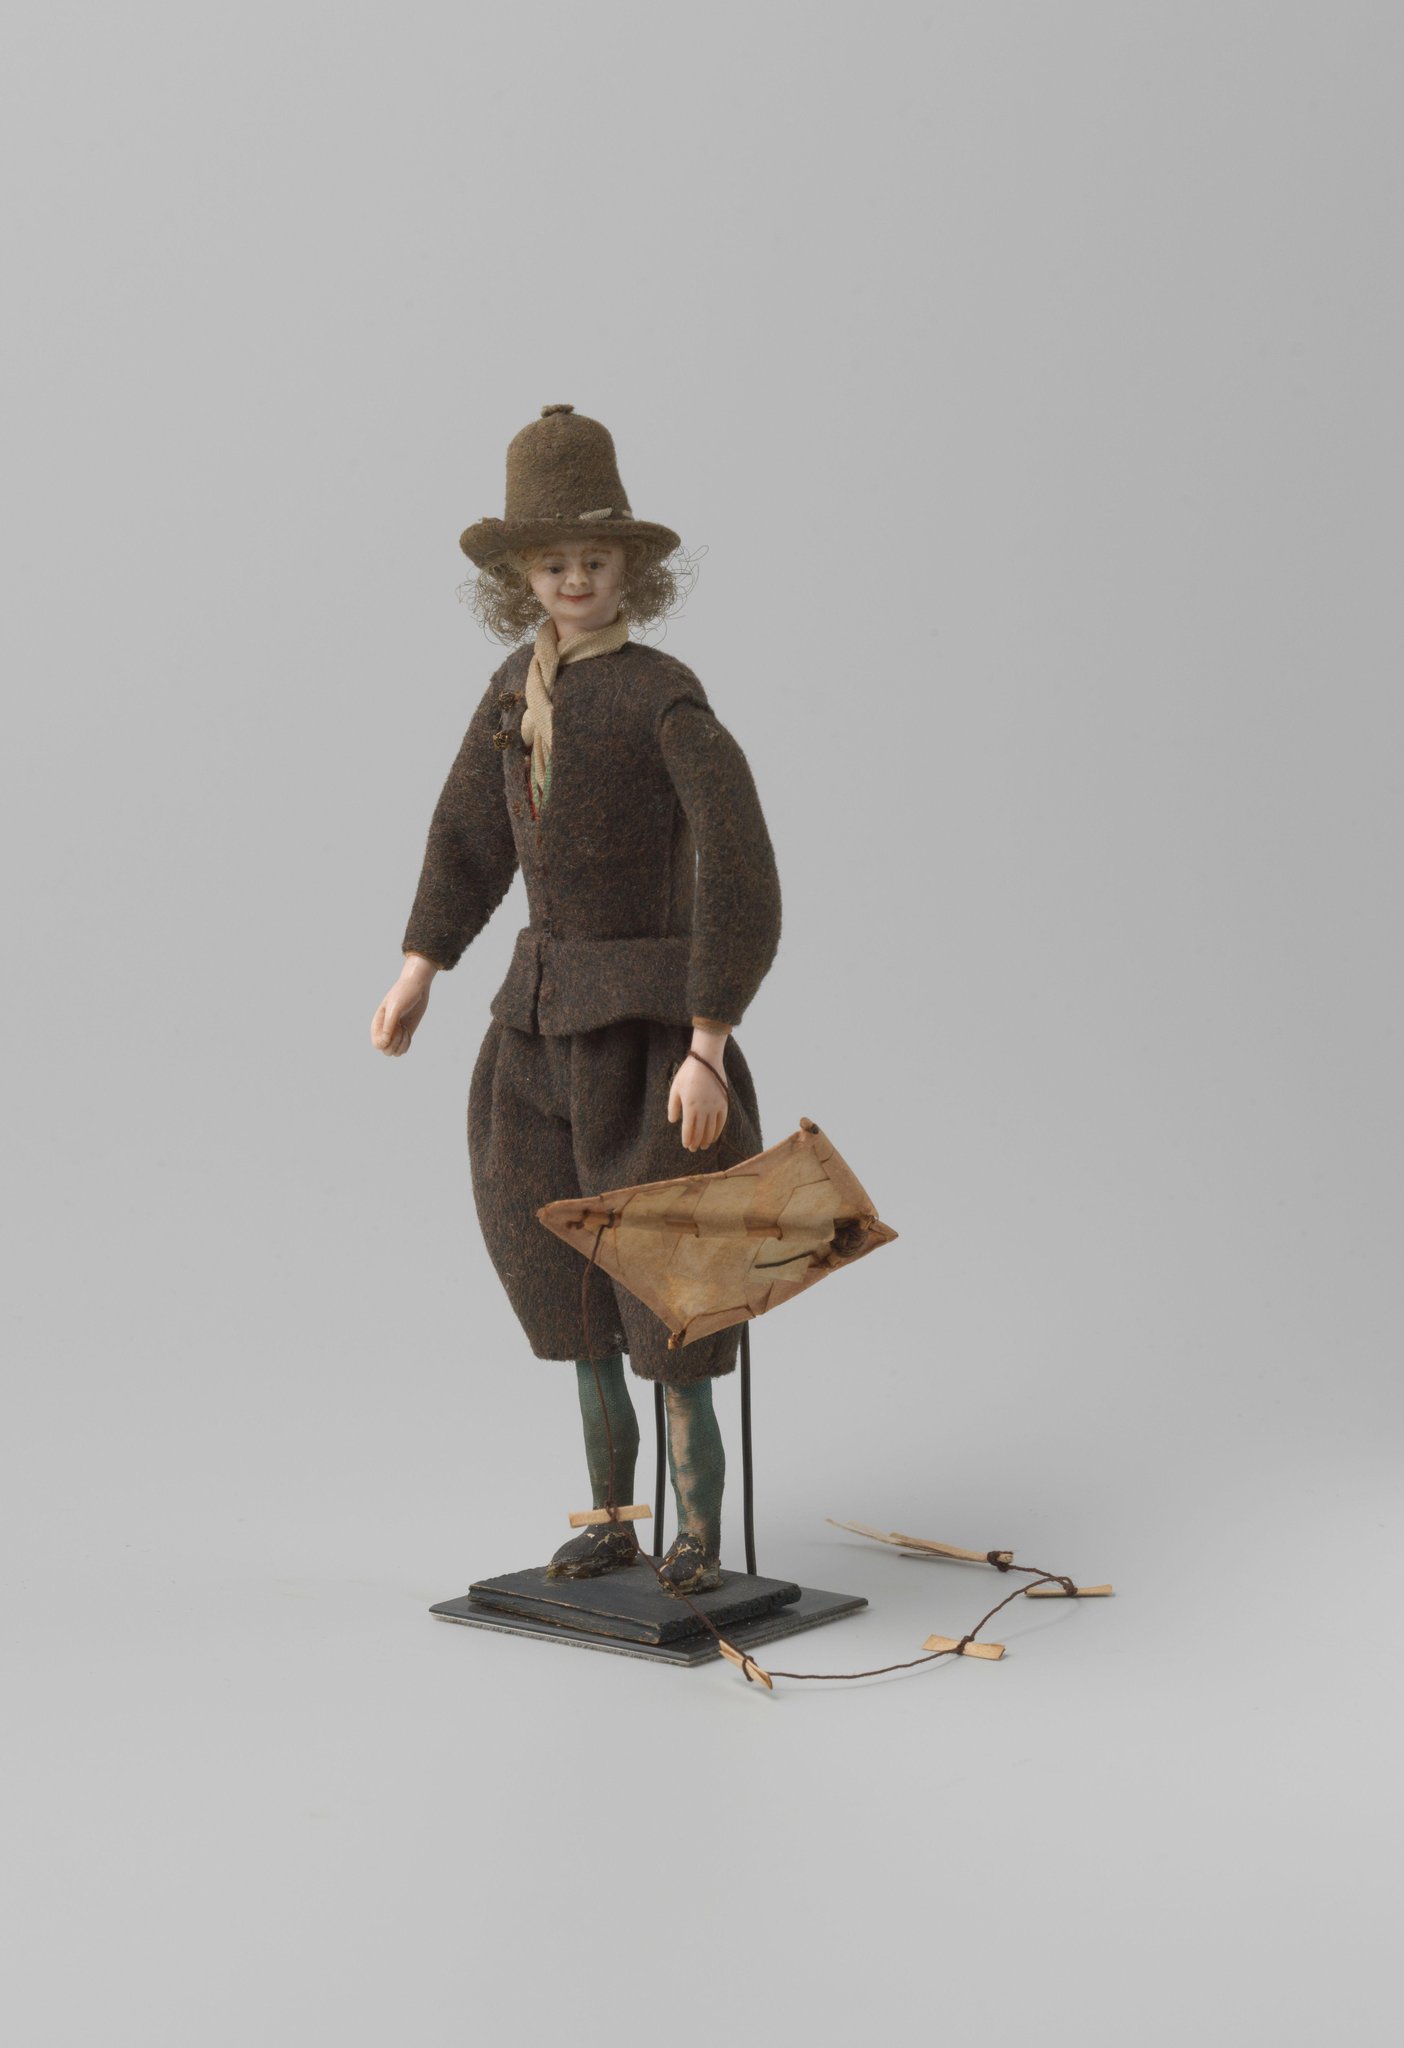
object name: miniature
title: Pop, voorstellende een boerenzoon genaamd Teunis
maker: Anonymous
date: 1676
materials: hair, linen, paper, silk, fiber, wax, wool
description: Pop, voorstellende een boerenzoon genaamd Teunis, gekleed in een nauwsluitend jak van bruin laken en een knielange broek van bruin laken. Hij houdt een papieren vlieger in de linkerhand.